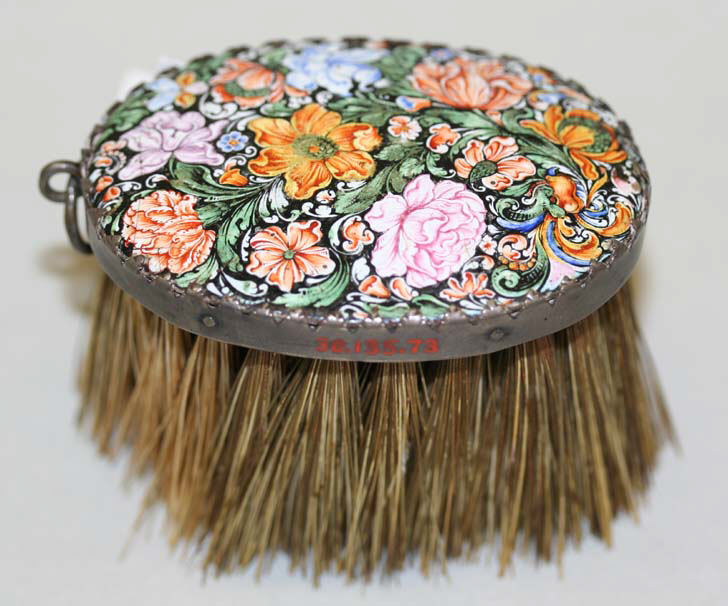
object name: brush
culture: french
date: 1601-1700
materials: enamel, metal